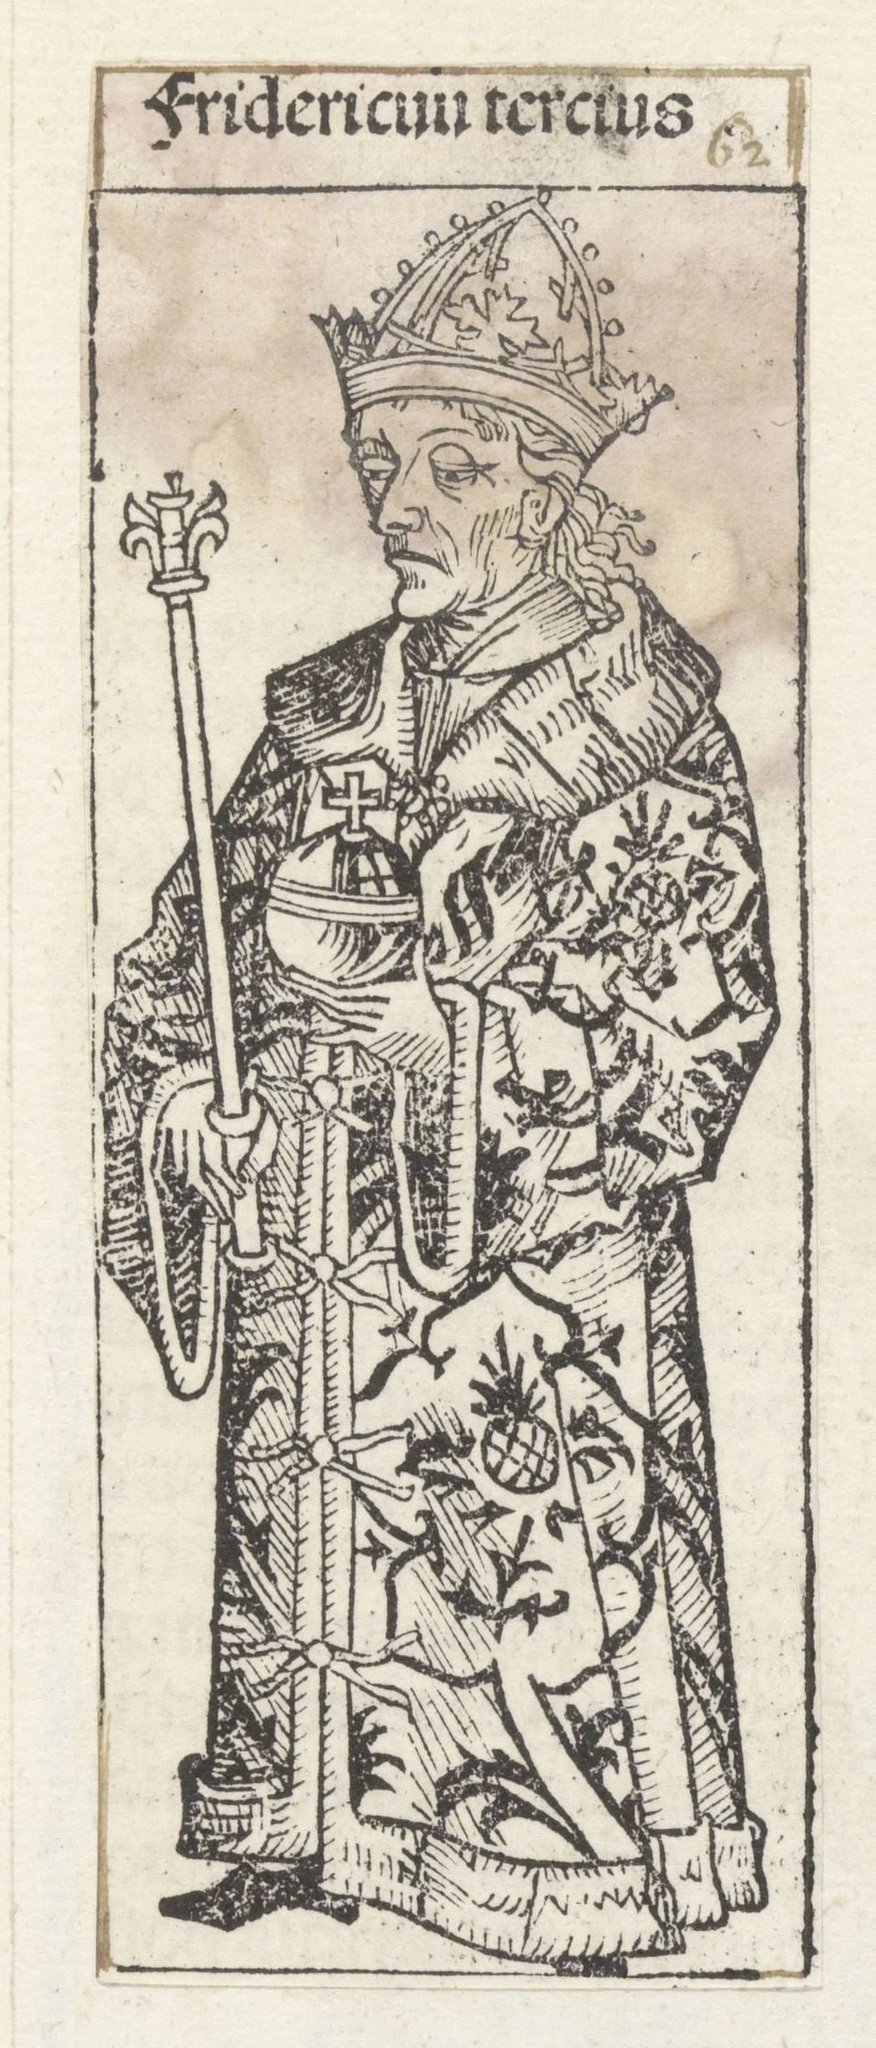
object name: album leaf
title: Liber Chronicarum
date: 1493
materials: paper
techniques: letterpress printing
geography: nuremberg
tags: emperor, king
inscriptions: inscription: ‘62’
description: Een koning met rijksappel en scepter, ten voeten uit. De voorstelling is onderdeel van de opeenvolging keizers in de Liber Chronicarum. De tekst identificeert de man als keizer Frederik III. De prent maakt deel uit van een album.